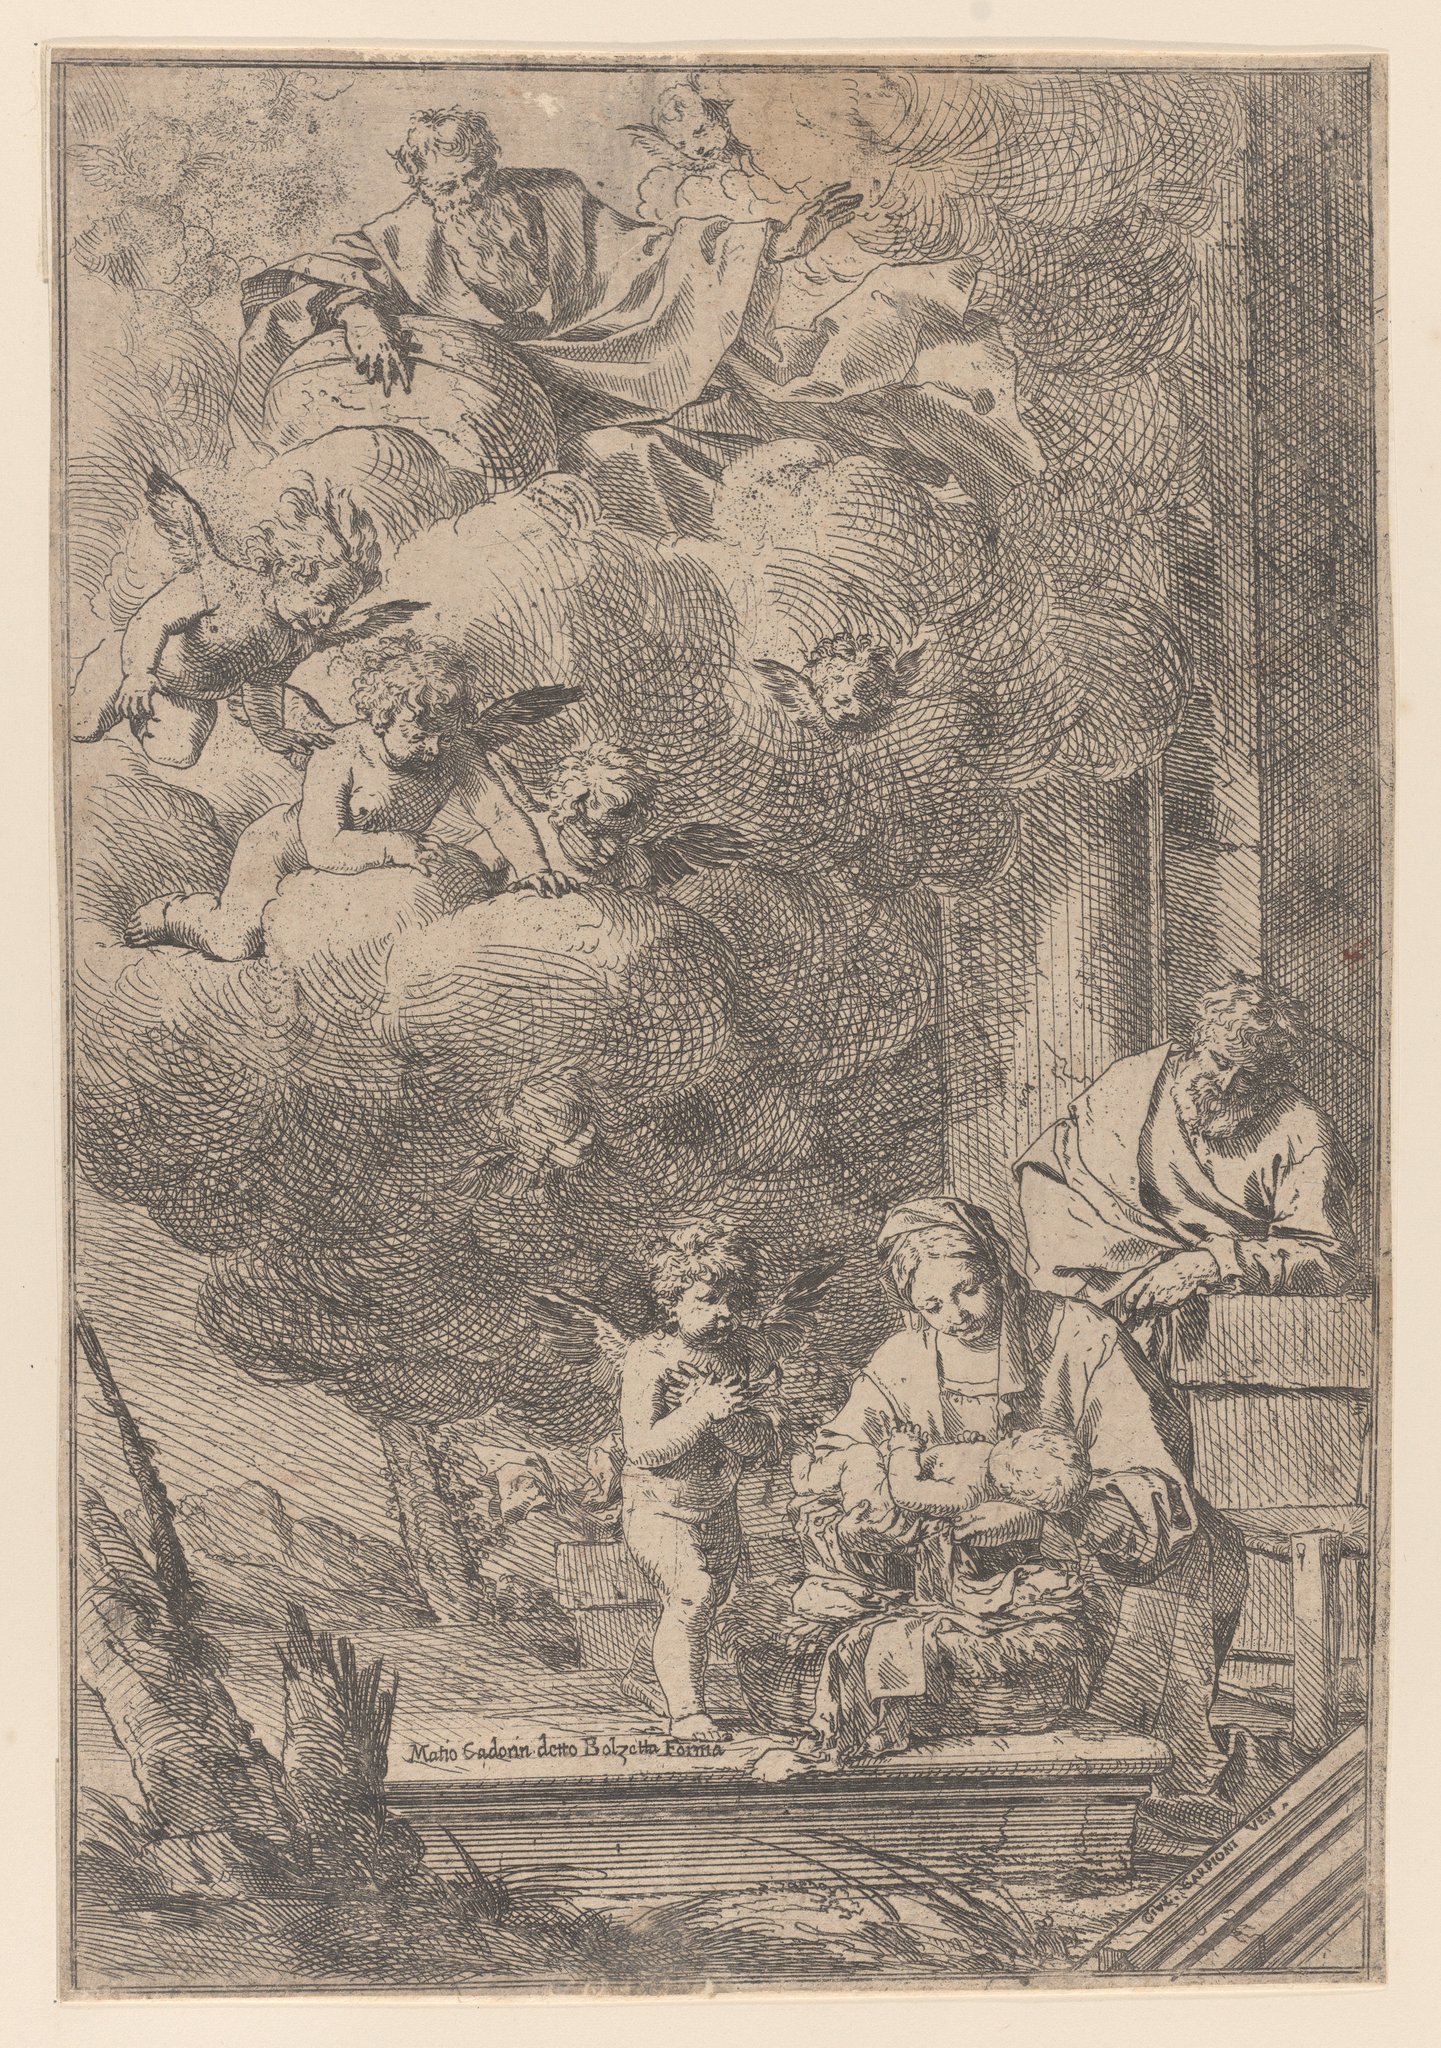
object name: print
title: The Holy Family with the Virgin holding Christ over the cradle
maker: giulio carpioni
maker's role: artist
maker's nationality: italian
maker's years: 1613-1678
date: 1640-1660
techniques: etching